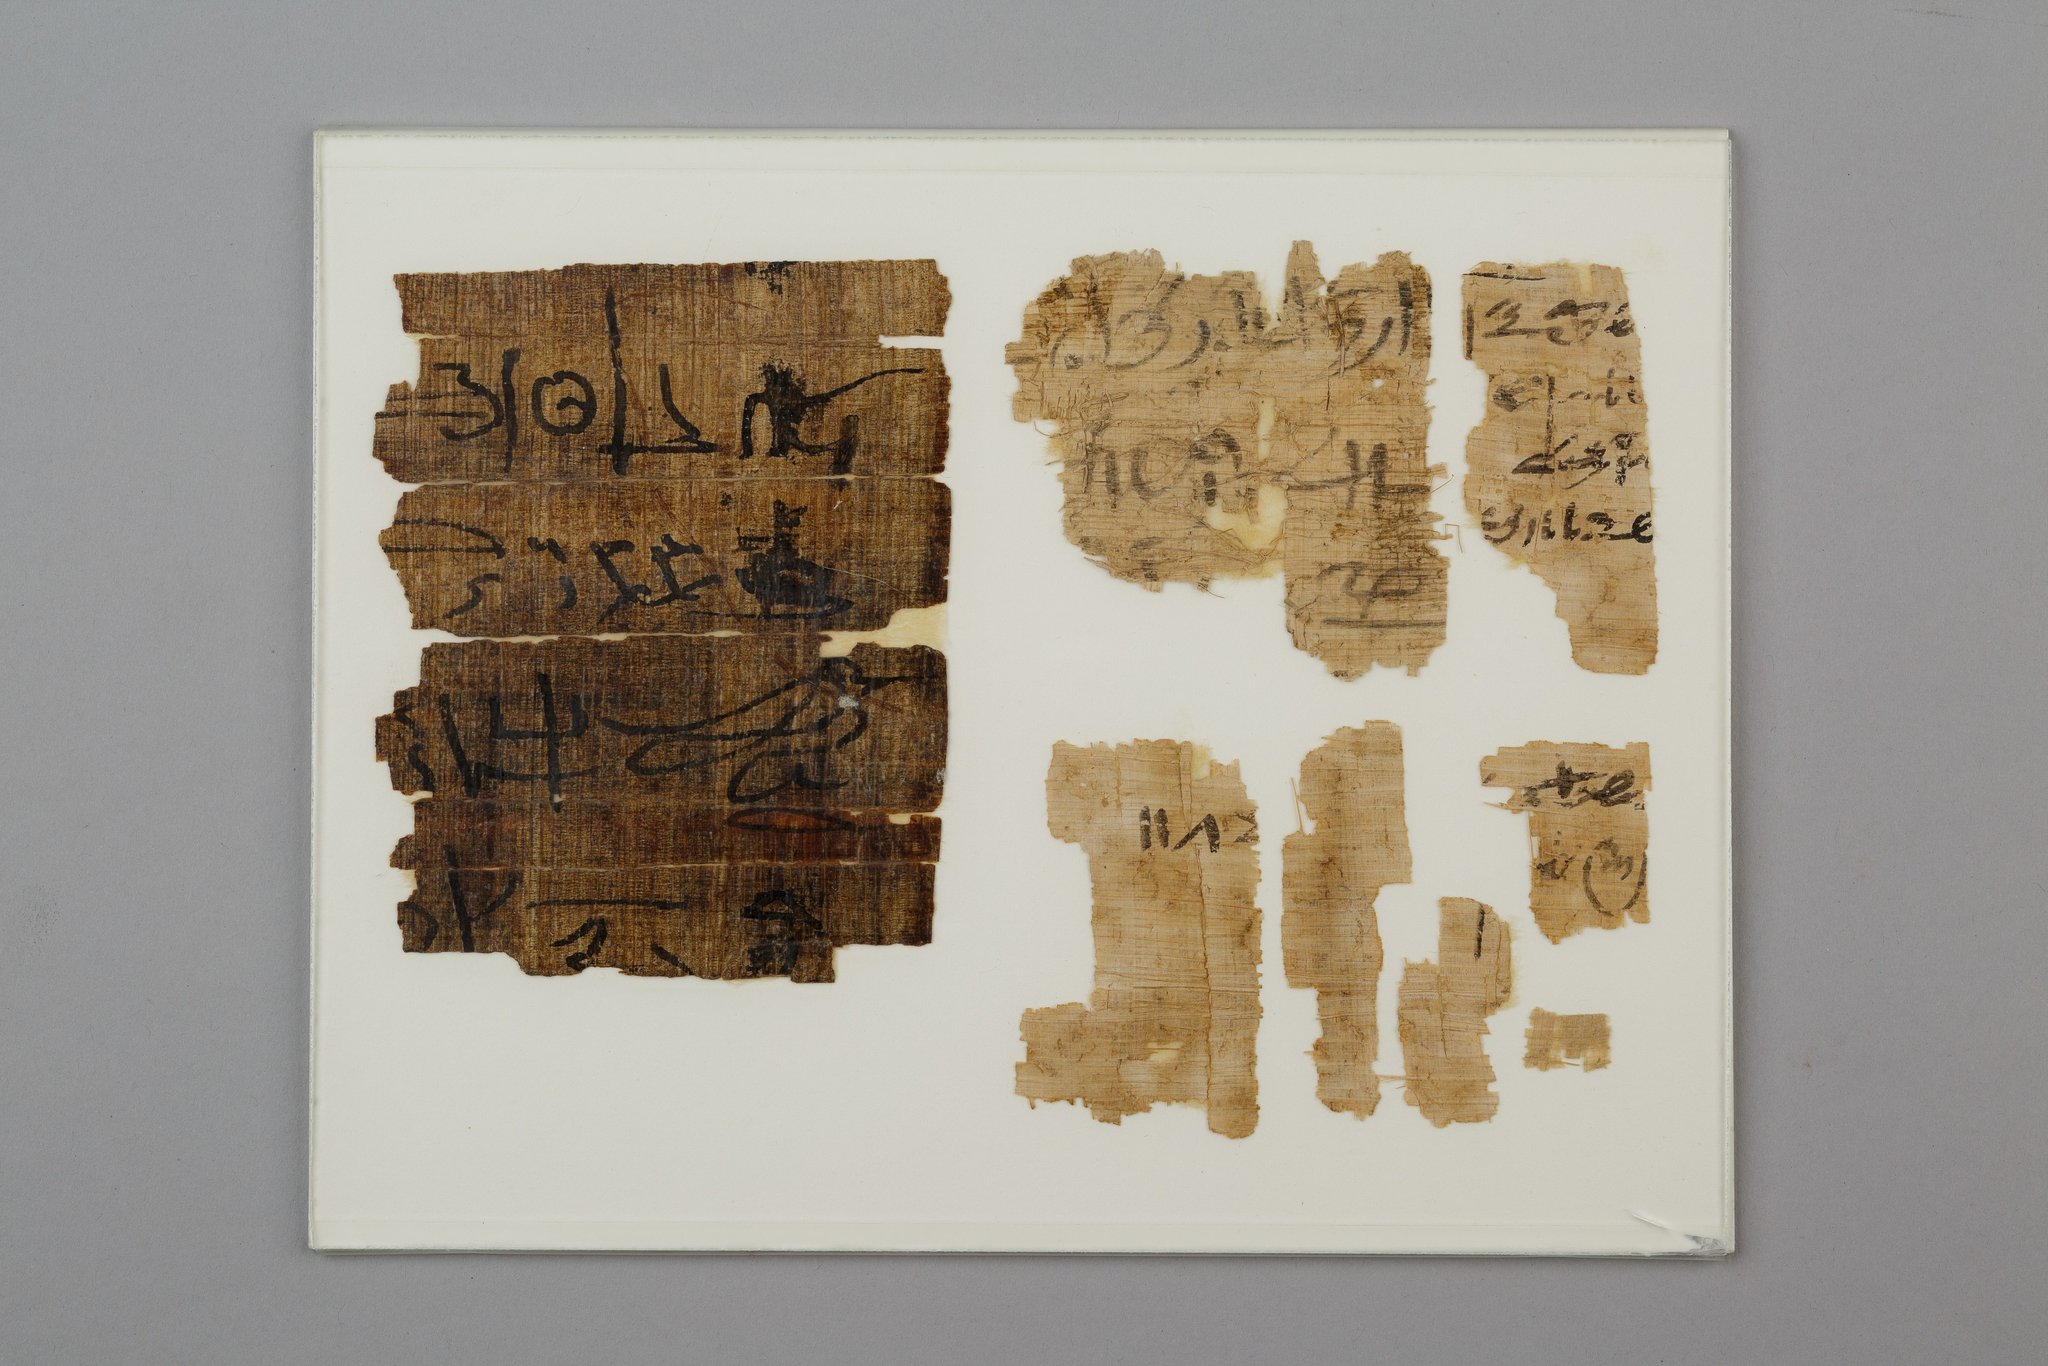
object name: papyrus, funerary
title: Fragments of Papyrus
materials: ink, papyrus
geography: egypt